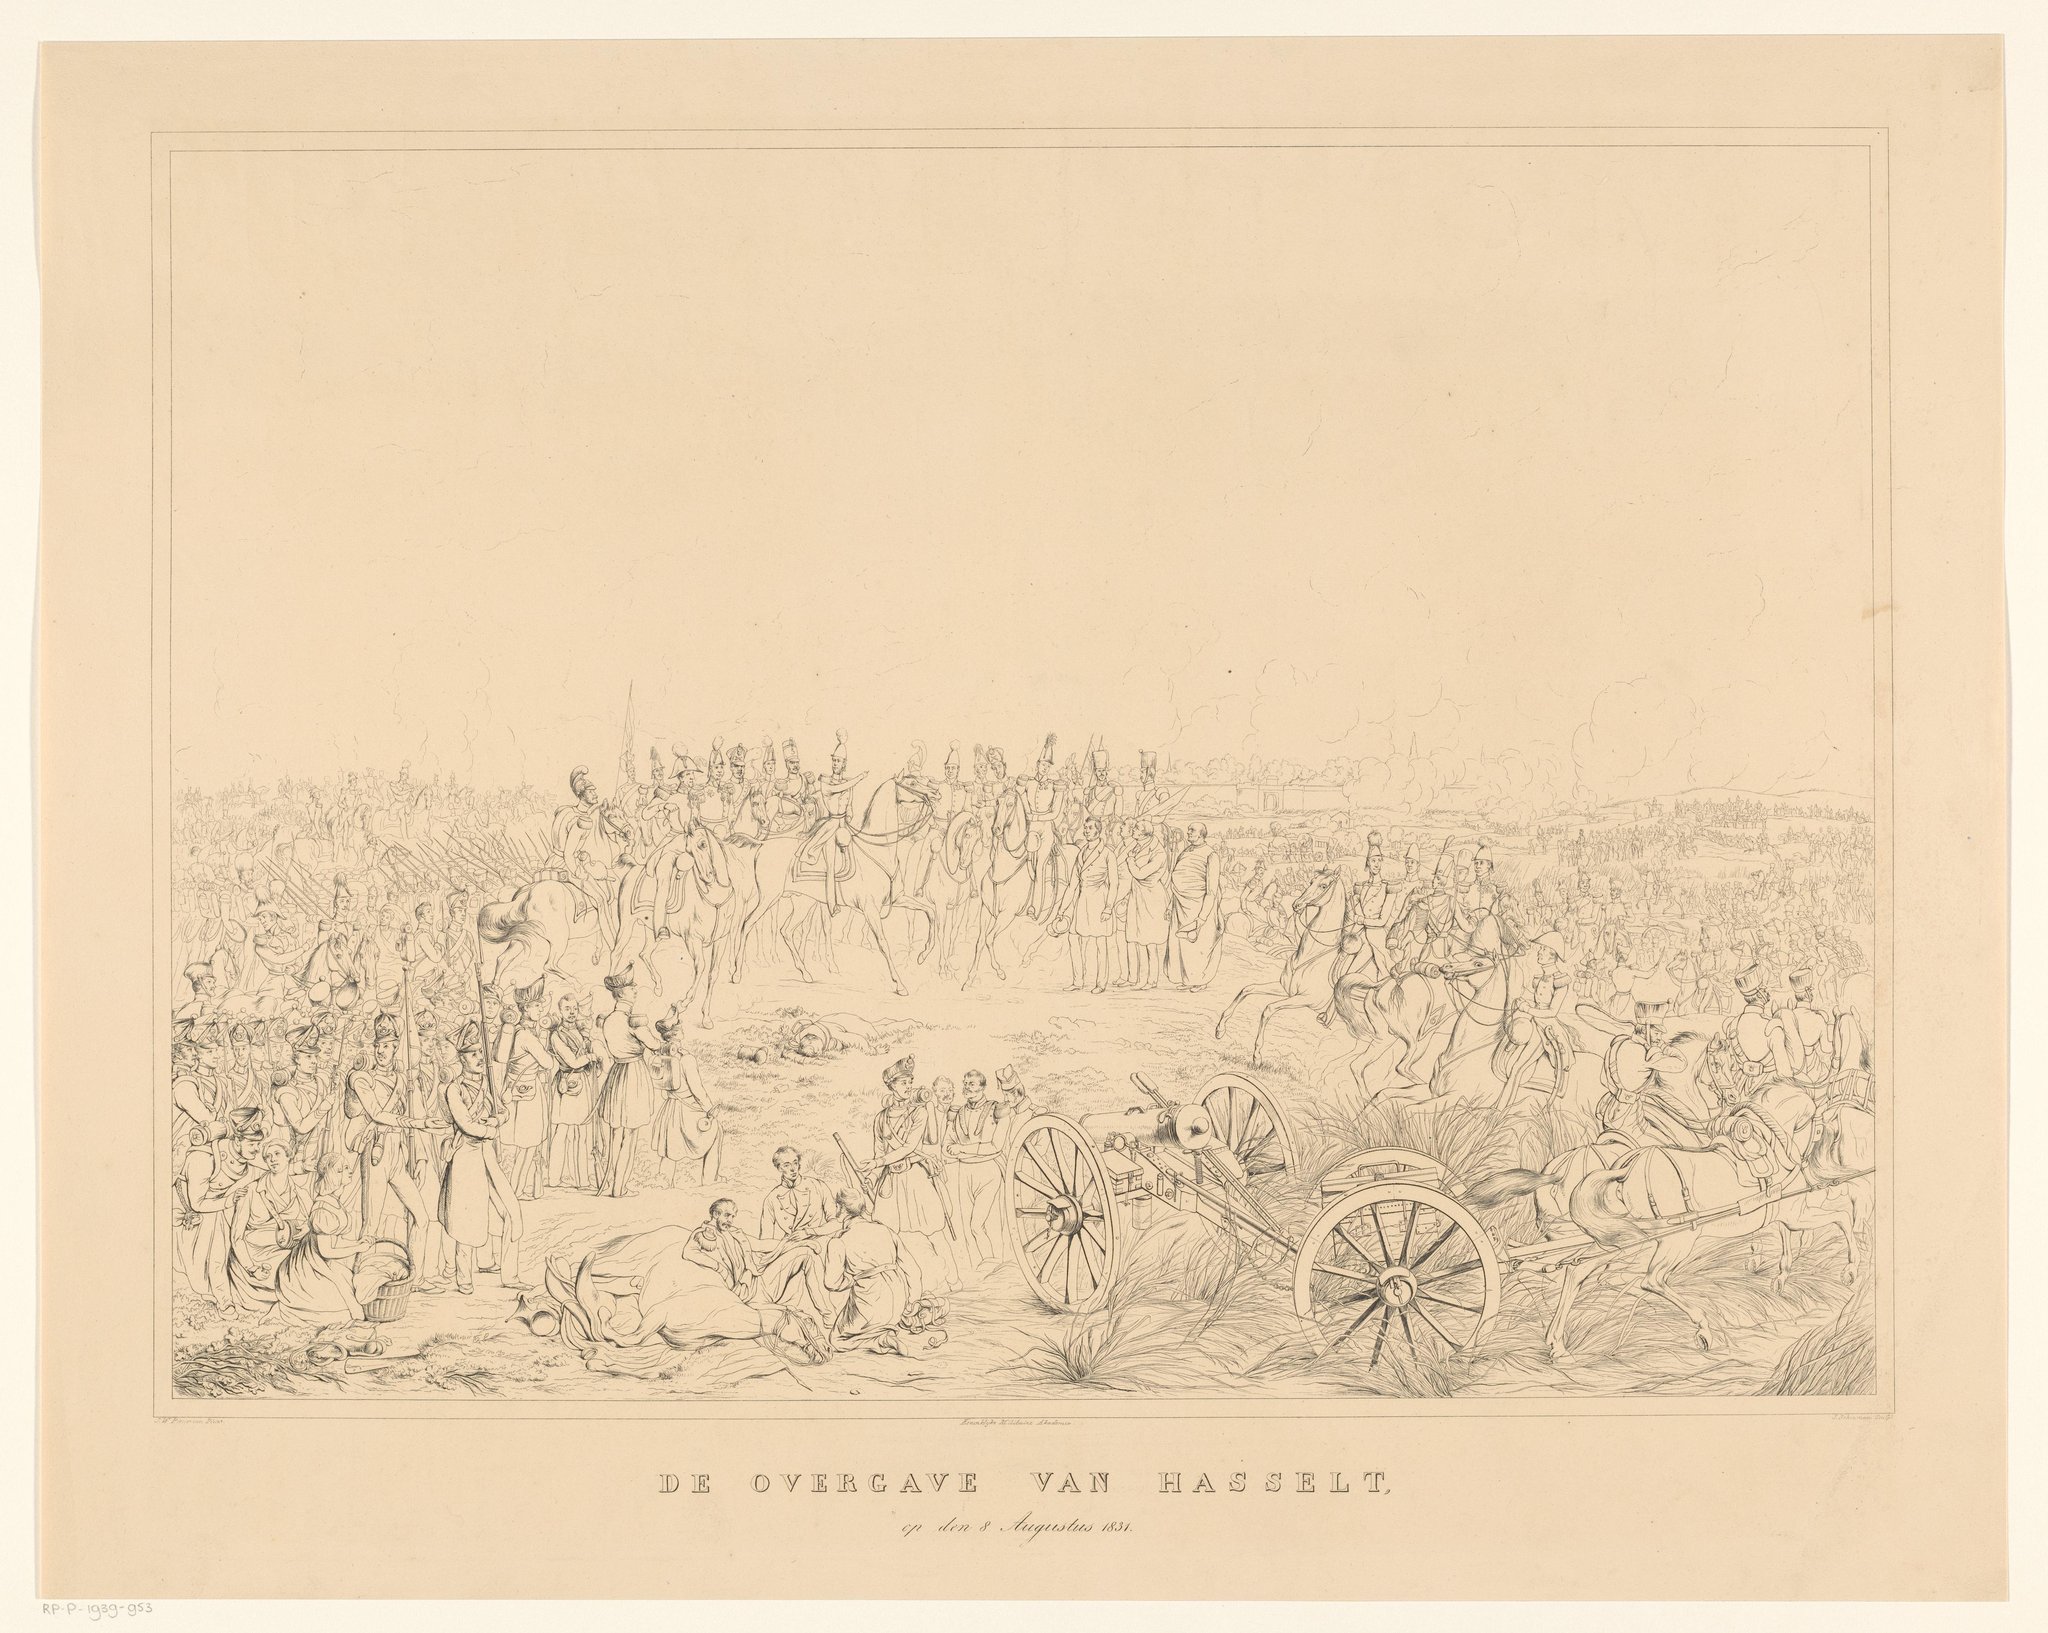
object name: print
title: De overgave van Hasselt, op den 8 Augustus 1831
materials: paper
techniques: lithograph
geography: breda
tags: william ii of the netherlands, berlin, frederik (prins der nederlanden), battle (+ land forces), surrender ~ war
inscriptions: collector's mark: Lugt 2228, watermark, collector's mark: Lugt 2760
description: De overgave van de stad Hasselt aan de Nederlandse troepen onder bevel van de prins van Oranje, 8 augustus 1831. Gezicht op het slagveld met centraal op een heuvel de prins omringd door zijn staf, allen te paard. Rechts van hen een afvaardiging van de stad Hasselt onder leiding van de burgemeester om over de overgave van de stad te onderhandelen. Rechts prins Frederik tussen enkele officieren. Op de voorgrond wordt een gewonde militair verzorgd. Aan de linkerkant leden van de Leidsche Vrijwillige Jagers en de Jagers van Rookmaker.